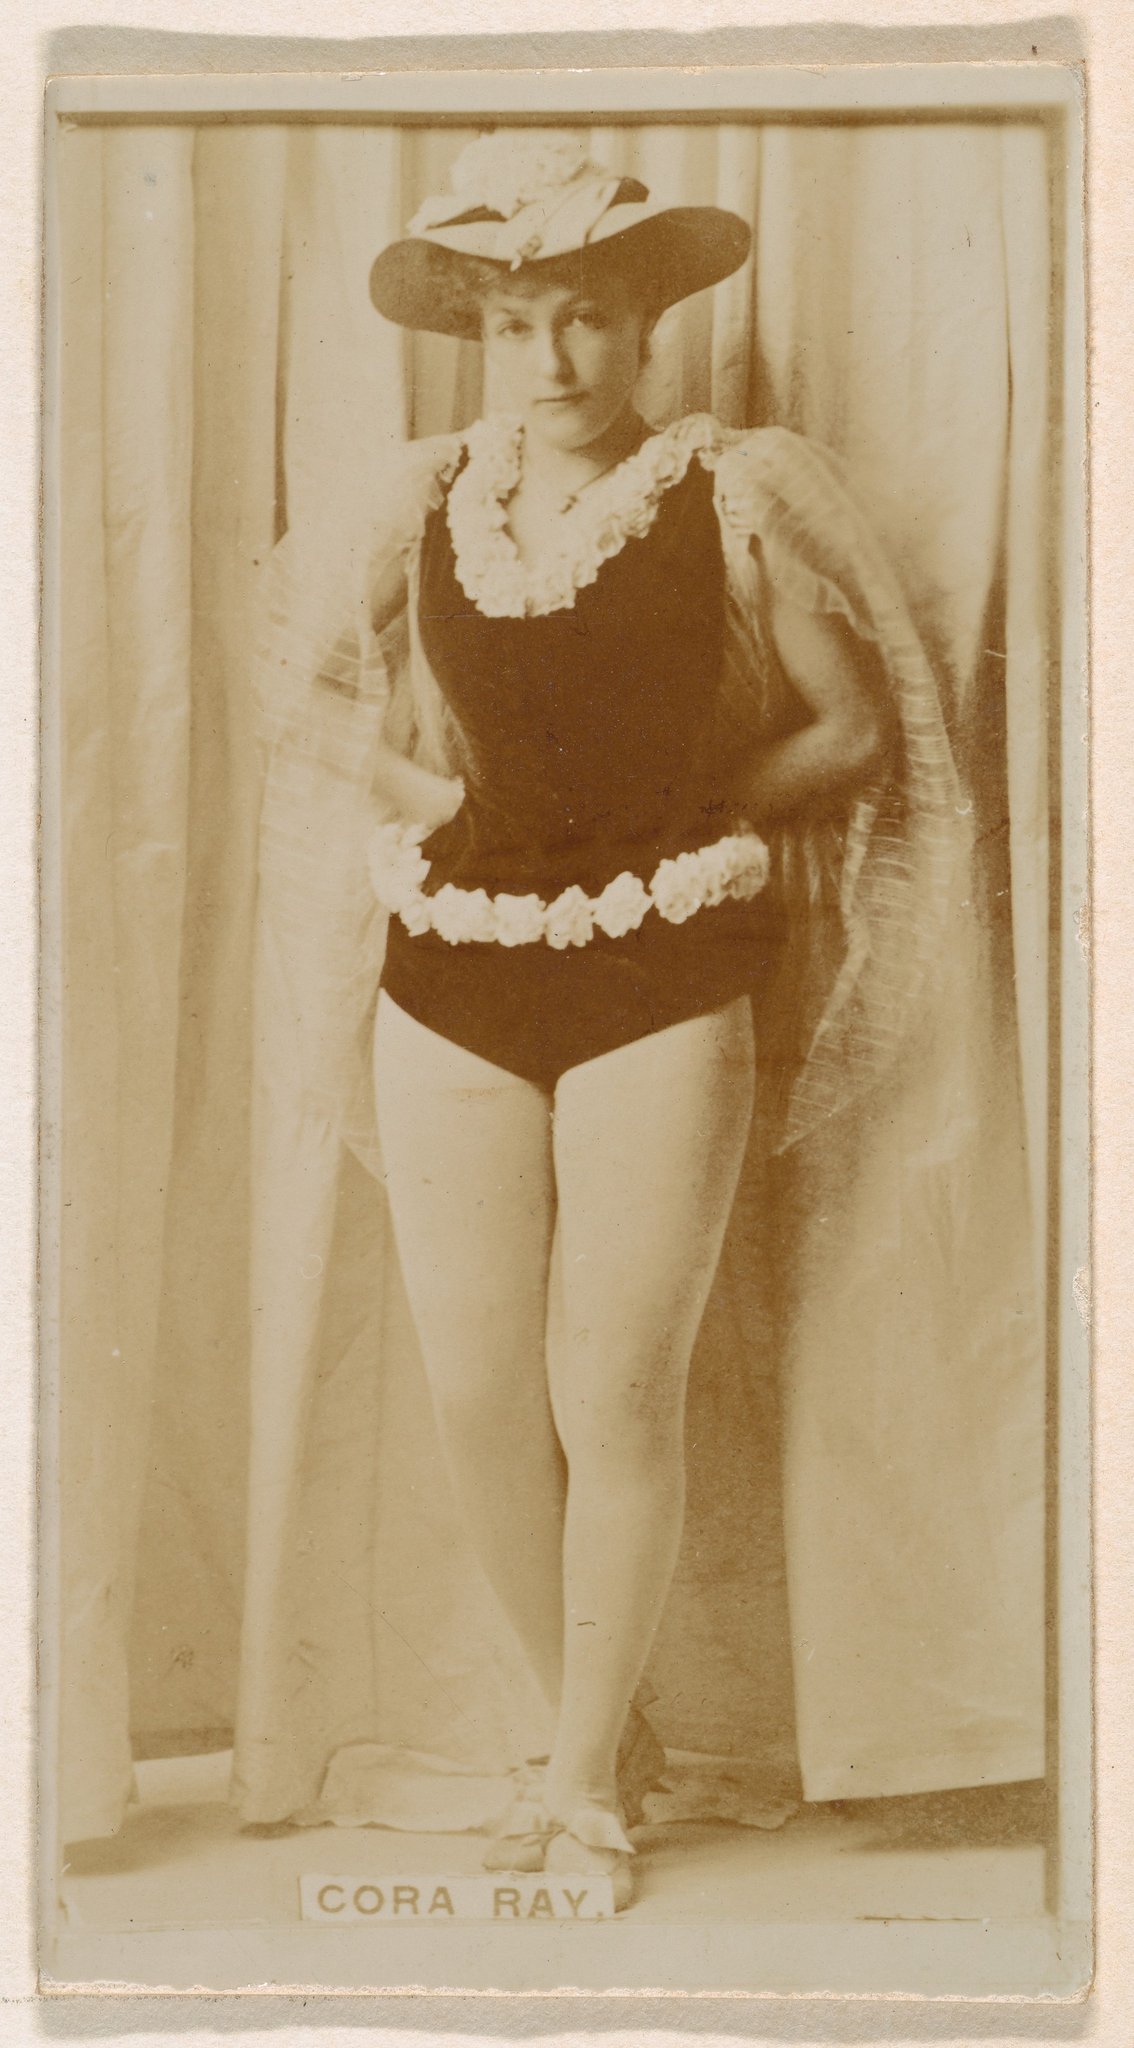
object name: photograph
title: Cora Ray, from the Actresses series (N245) issued by Kinney Brothers to promote Sweet Caporal Cigarettes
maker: kinney brothers tobacco company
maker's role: publisher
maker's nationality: american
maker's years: 1869-2011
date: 1890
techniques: albumen silver print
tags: portraits,women,actresses